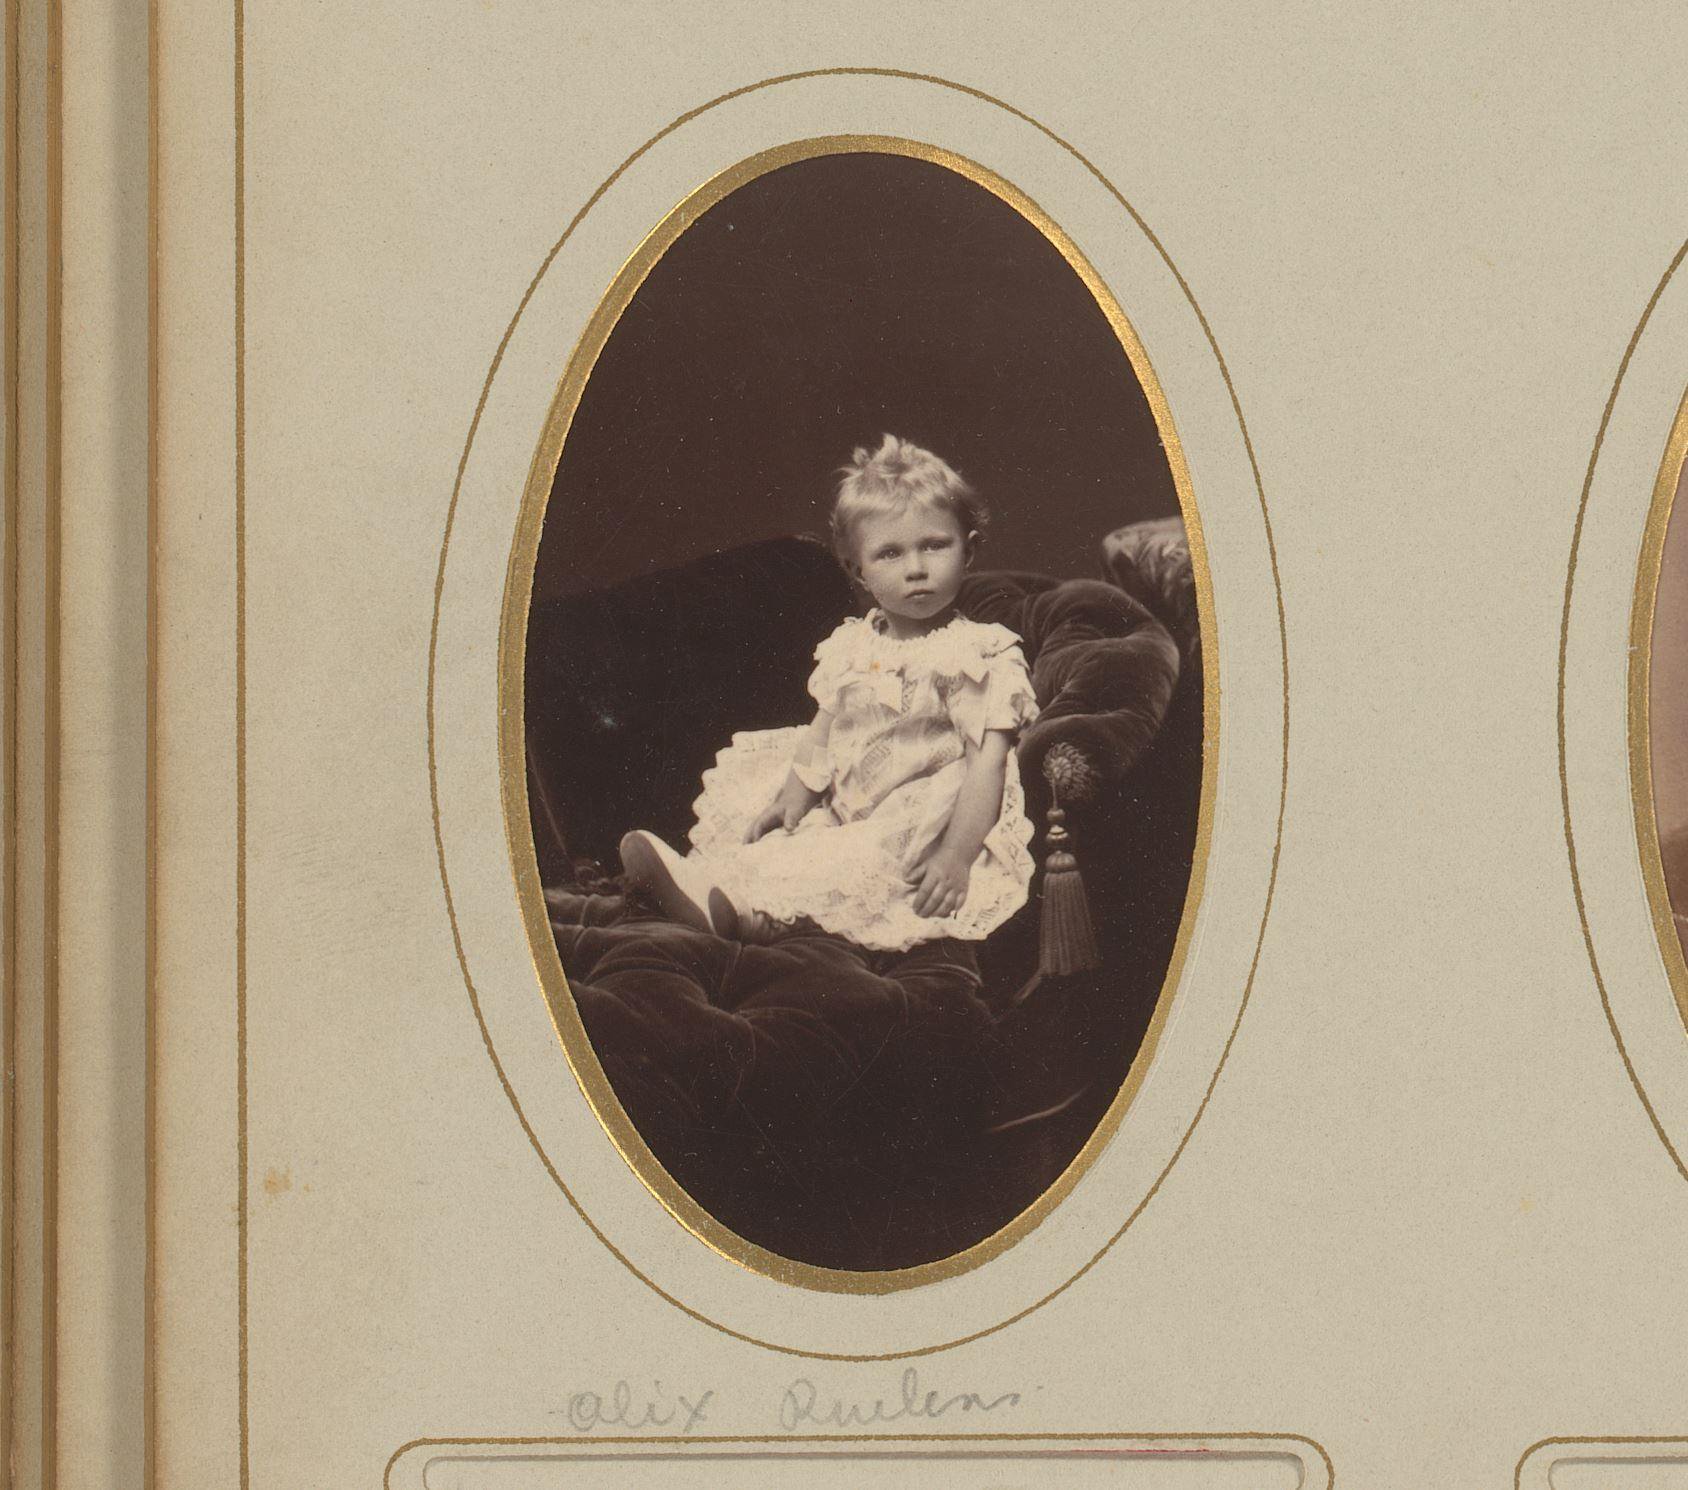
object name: photograph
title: Portret van een zittend meisje, aangeduid als Alix Rubens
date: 1866-1890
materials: cardboard, paper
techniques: carbon print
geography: brussels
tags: sitting figure - aa - female human figure, historical persons - bb - woman, toddler (female)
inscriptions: name: ‘Alix Rubens’, inscription: ‘Procédé inaltérable/ Photographie au Charbon/ (...)/ Géruzet Frères/ Photographes de S.M. la Reine des Belges/ 27b. Rue de l'Ecuyer/ Bruxelles’